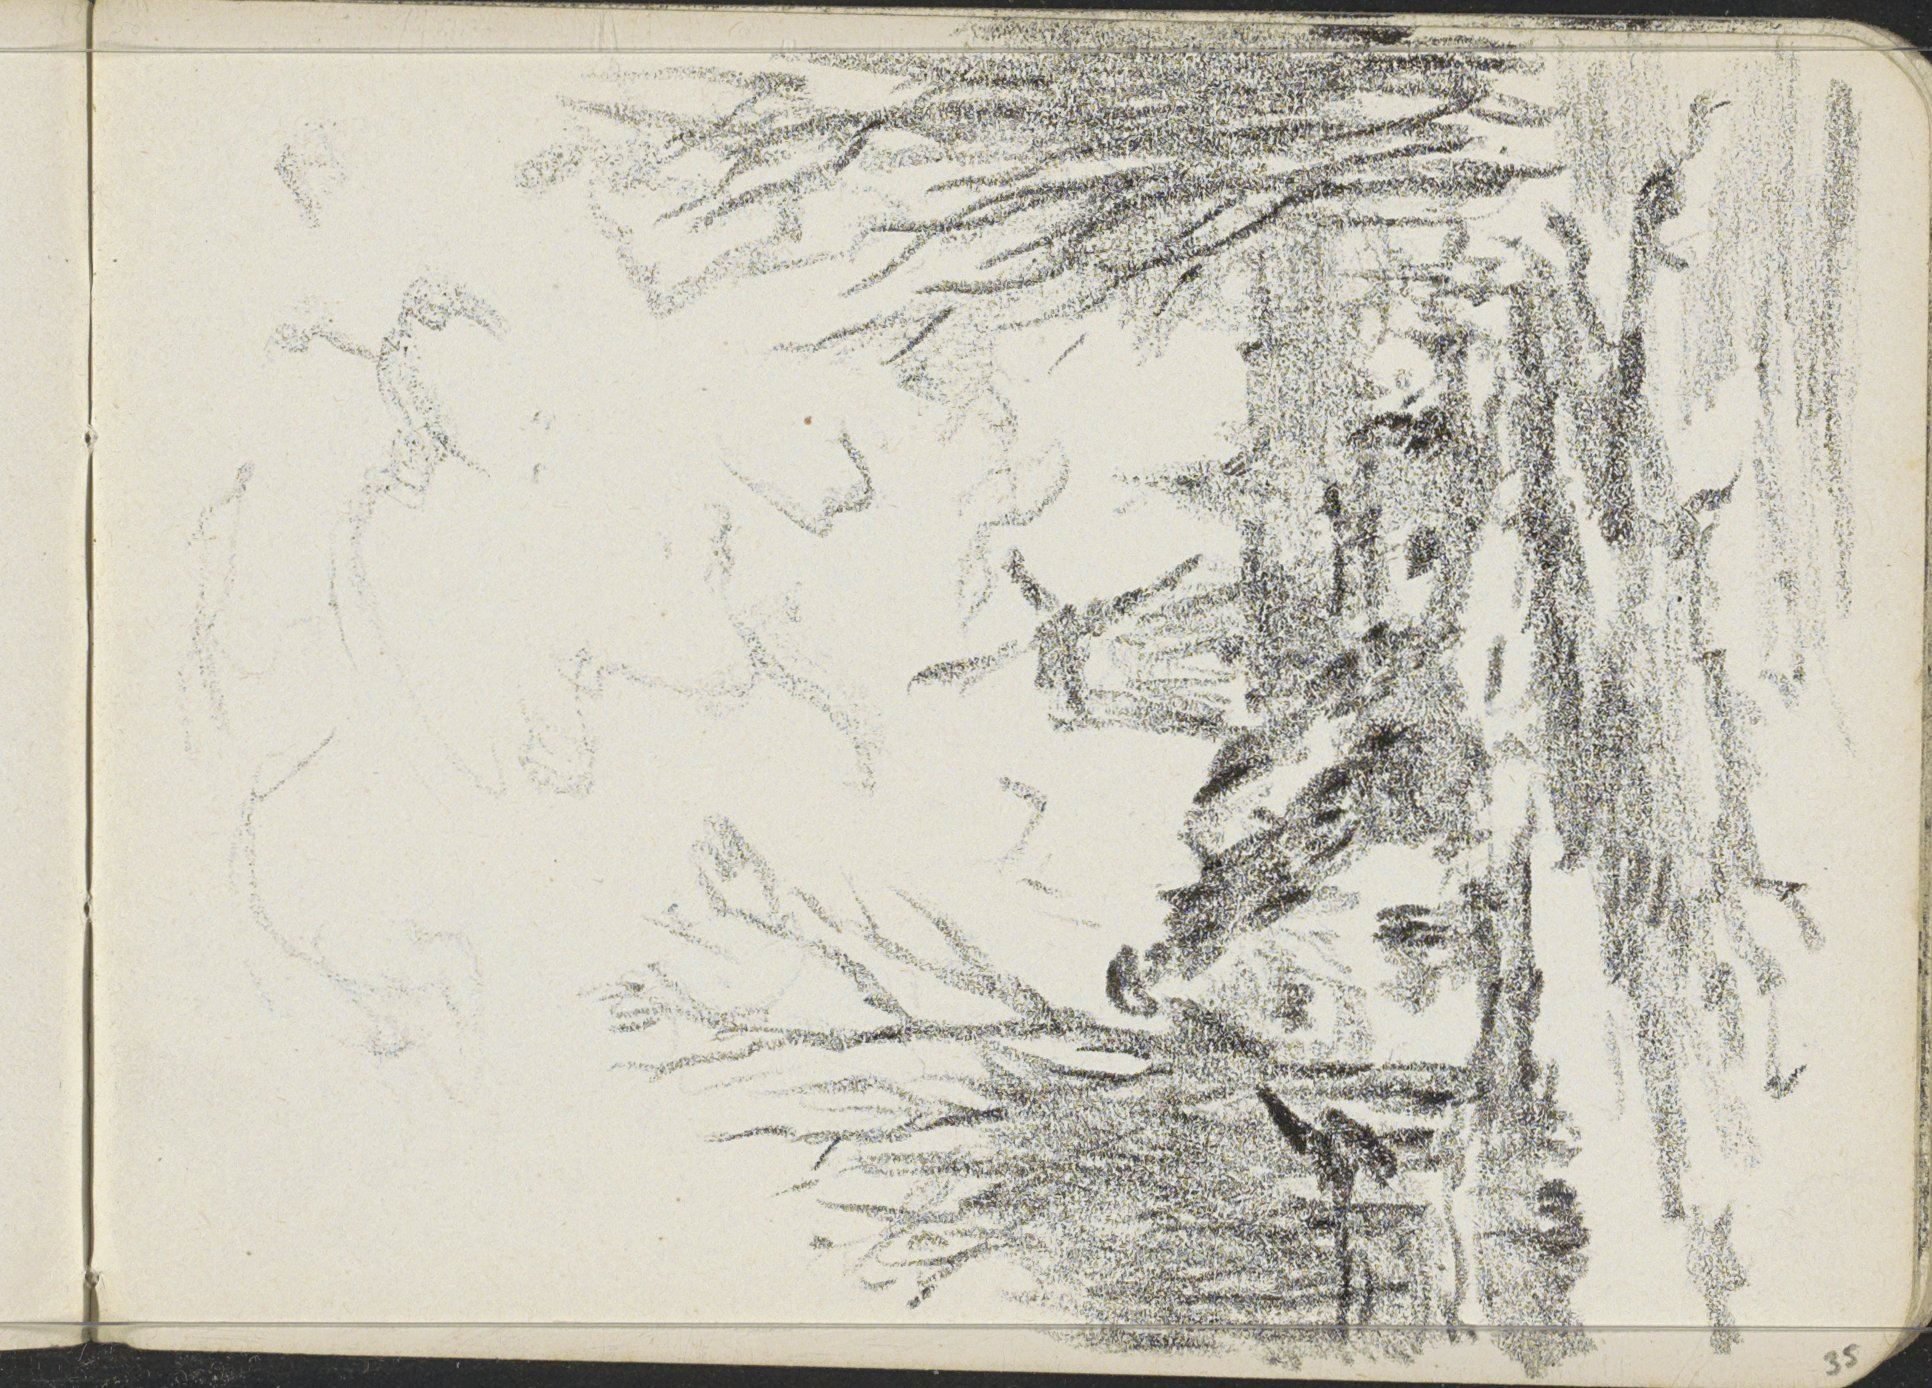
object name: sketchbook leaf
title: Landschap met boerderijen en een molen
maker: willem cornelis rip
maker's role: draughtsman, painter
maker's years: 1856-1922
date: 1907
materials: chalk, paper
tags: windmill in landscape, farm (building)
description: Blad 35 recto uit een schetsboek met 41 bladen.